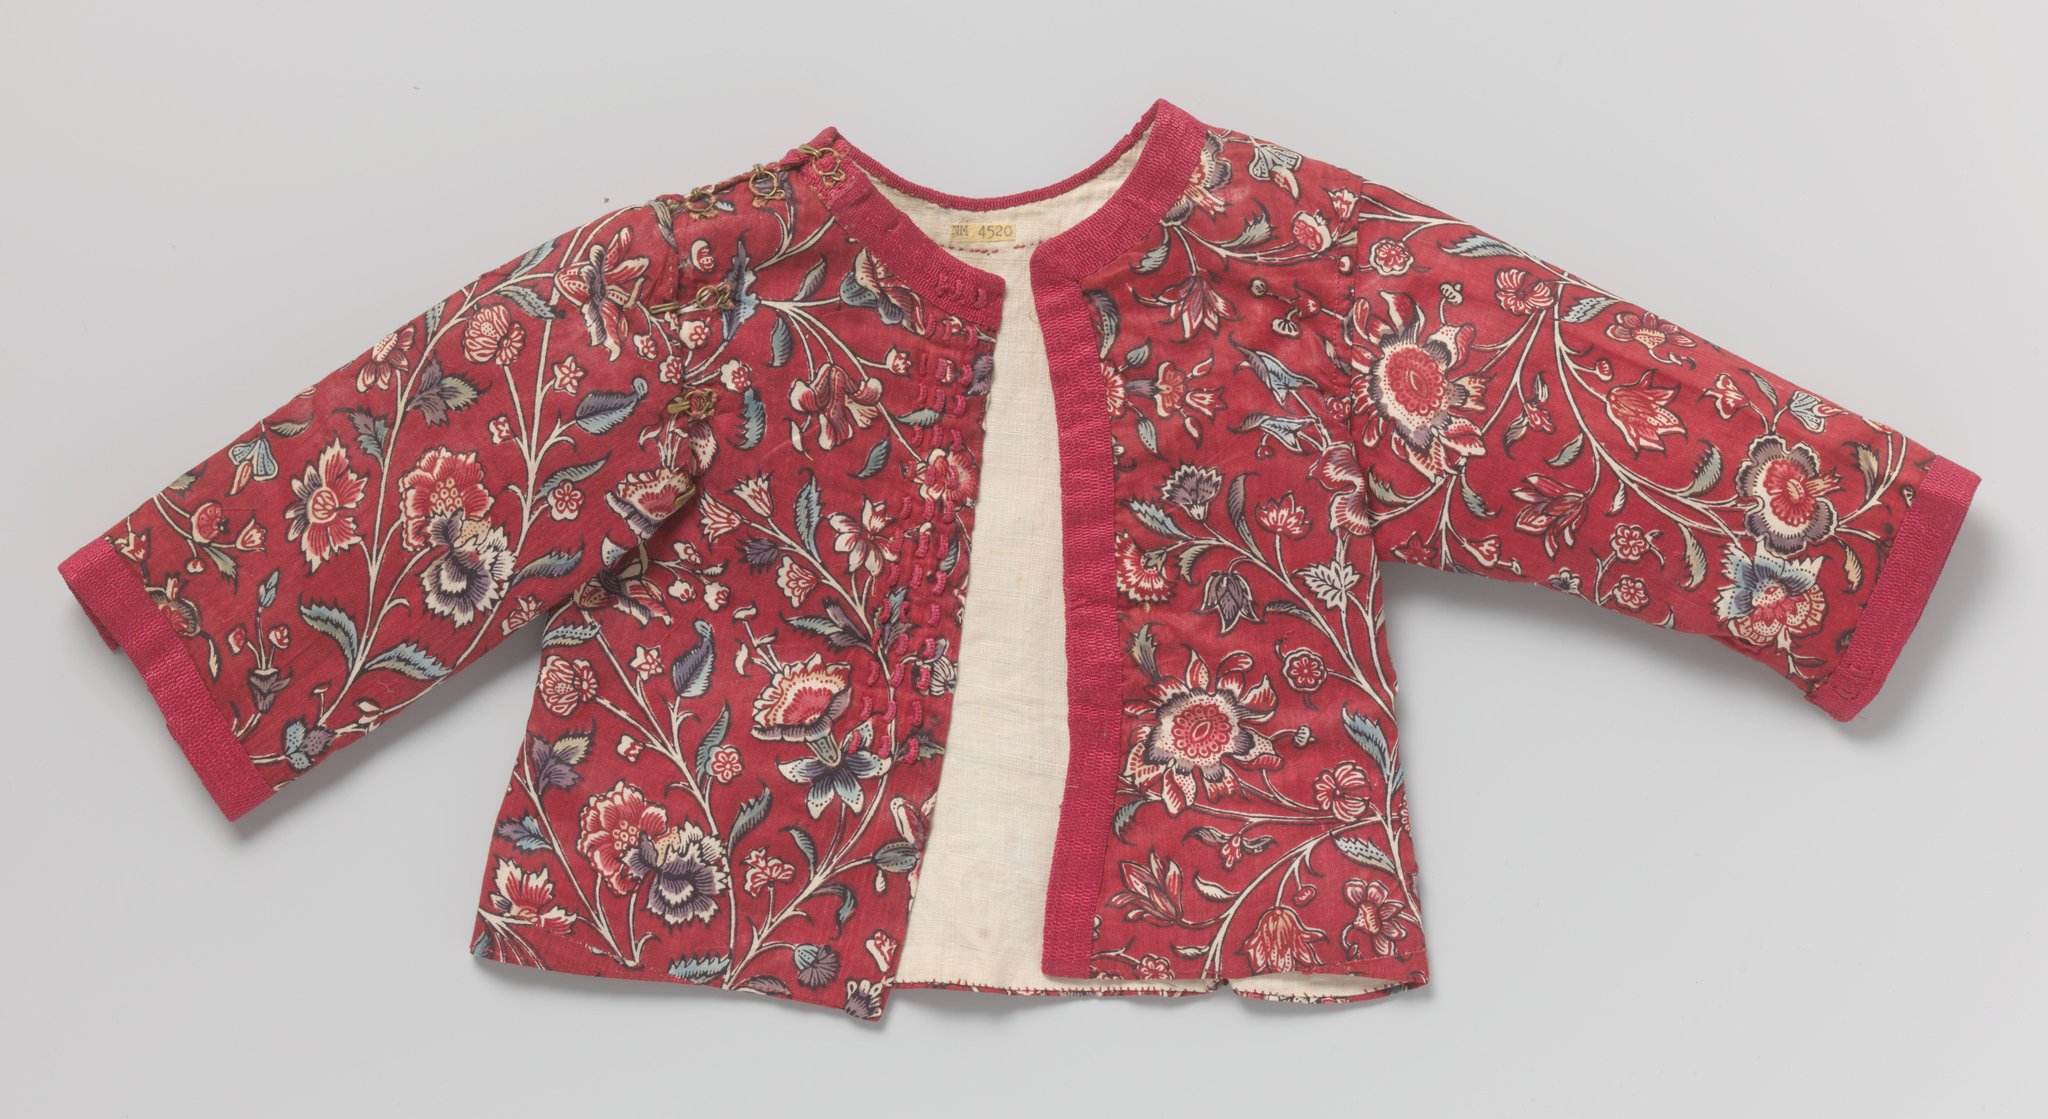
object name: jasje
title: Jasje voor baby van sits met een rood fond, langs de mouwen, hals en langs één voorpand afgebiesd met rood linnen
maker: Anonymous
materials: textile, cotton, linen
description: Jasje voor baby met lange mouw van sits met een rood fond, langs de mouwen, hals en langs één voorpand afgebiesd met rood linnen; voering van wit linnen.